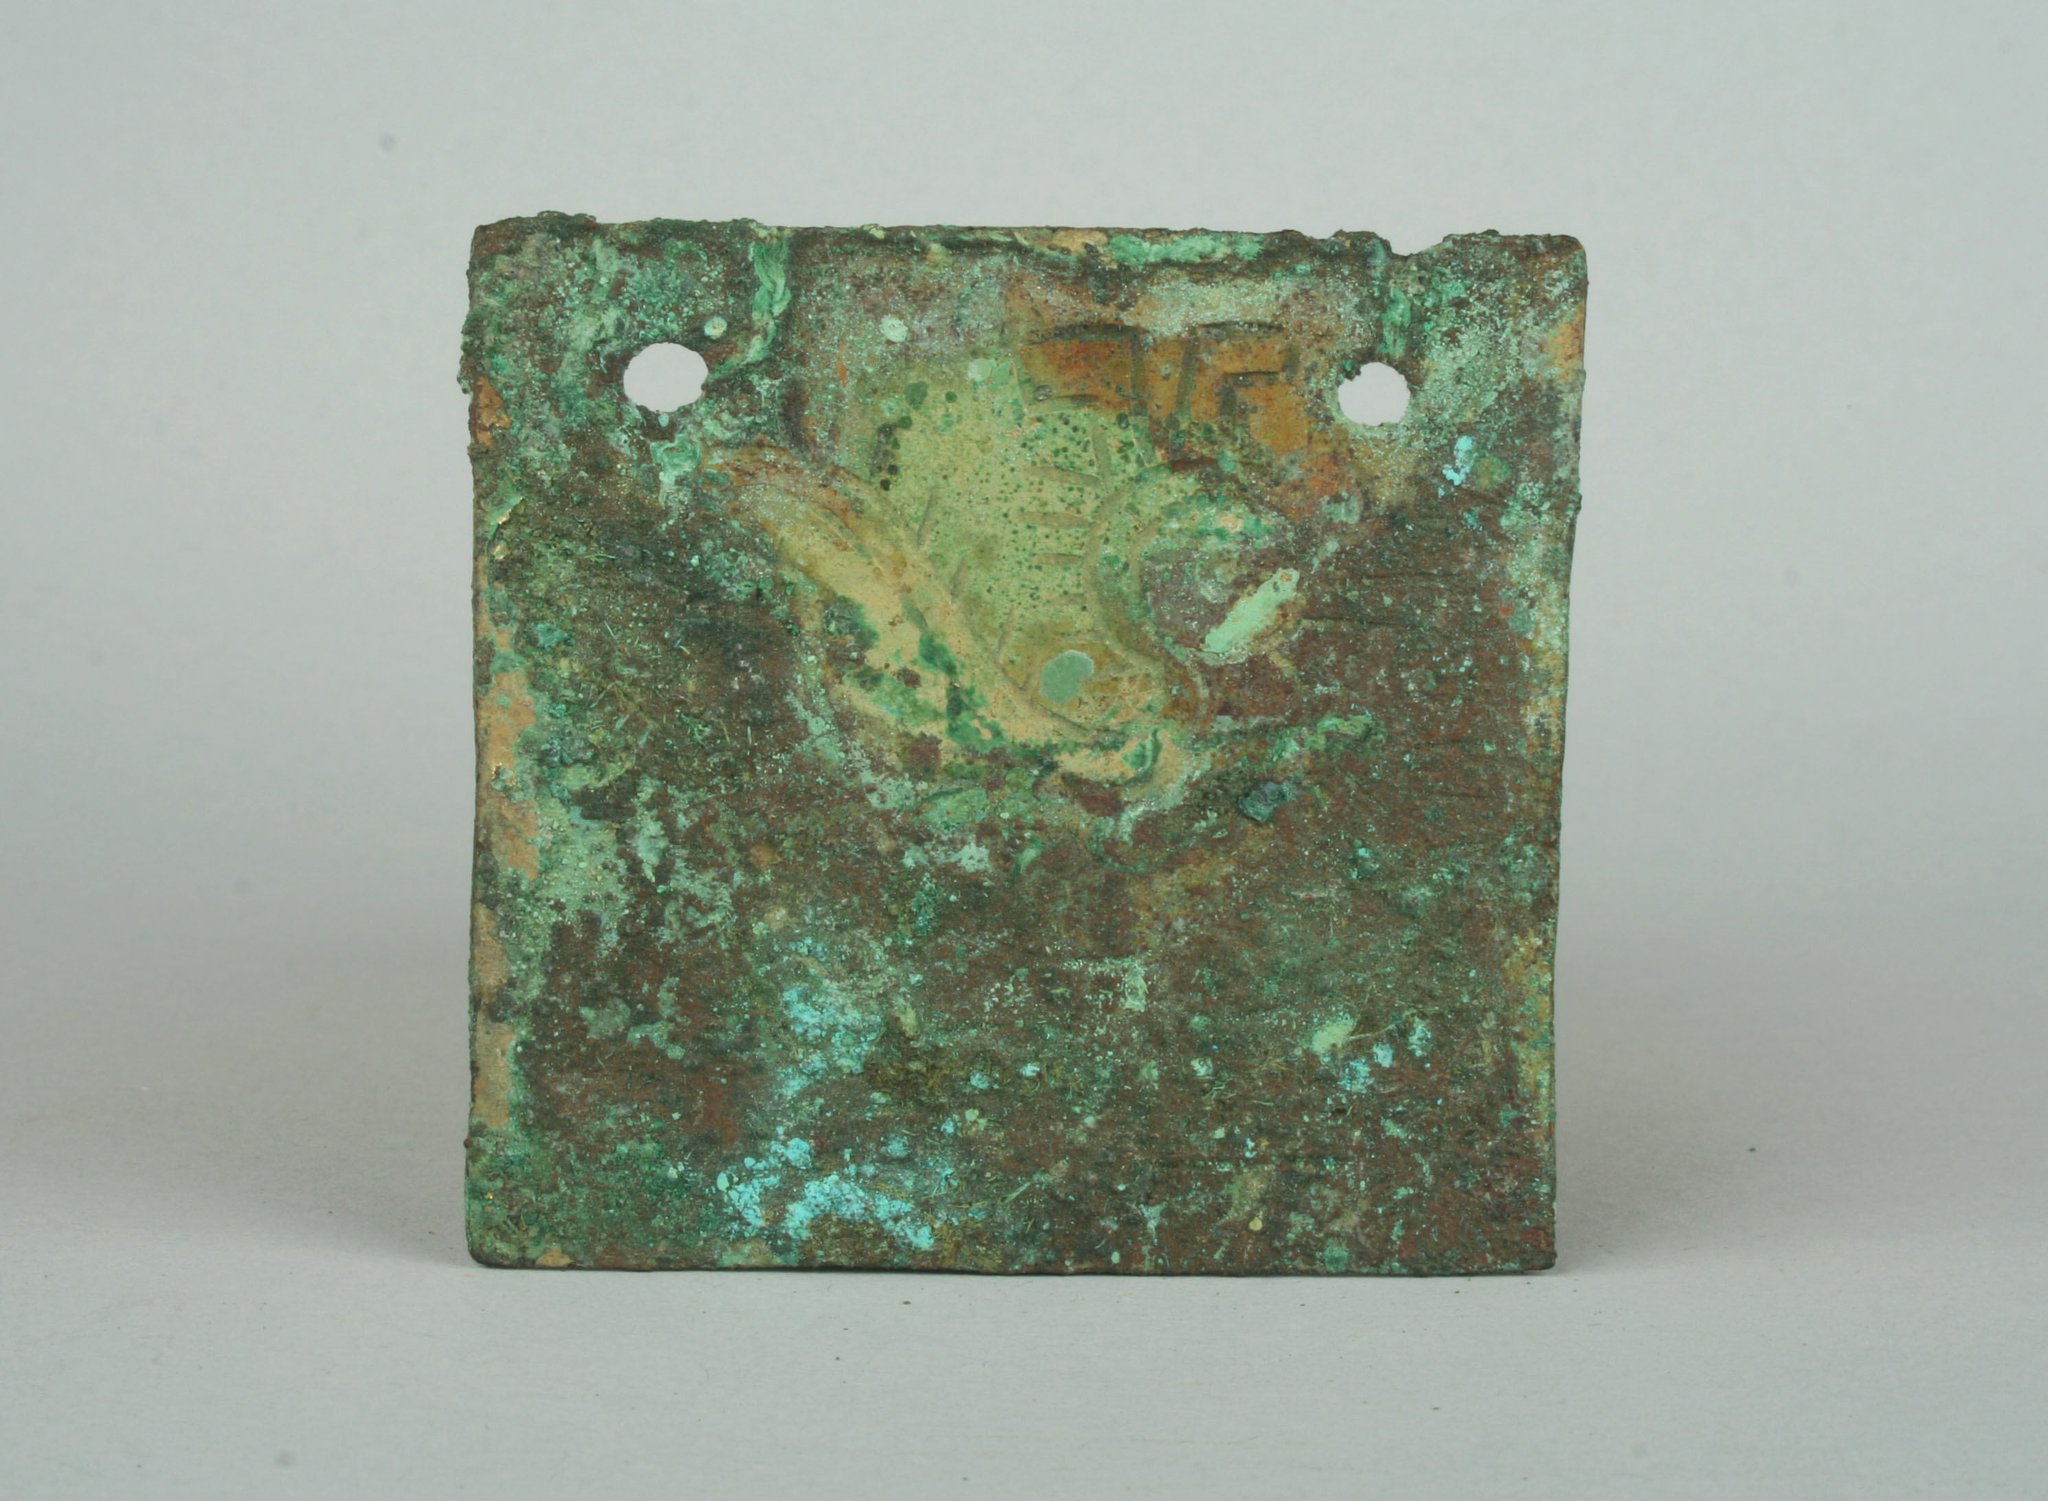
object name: ornament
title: Bird Plaque Ornament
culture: vicús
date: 300 BCE-200 CE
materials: copper, gilt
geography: peru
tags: birds